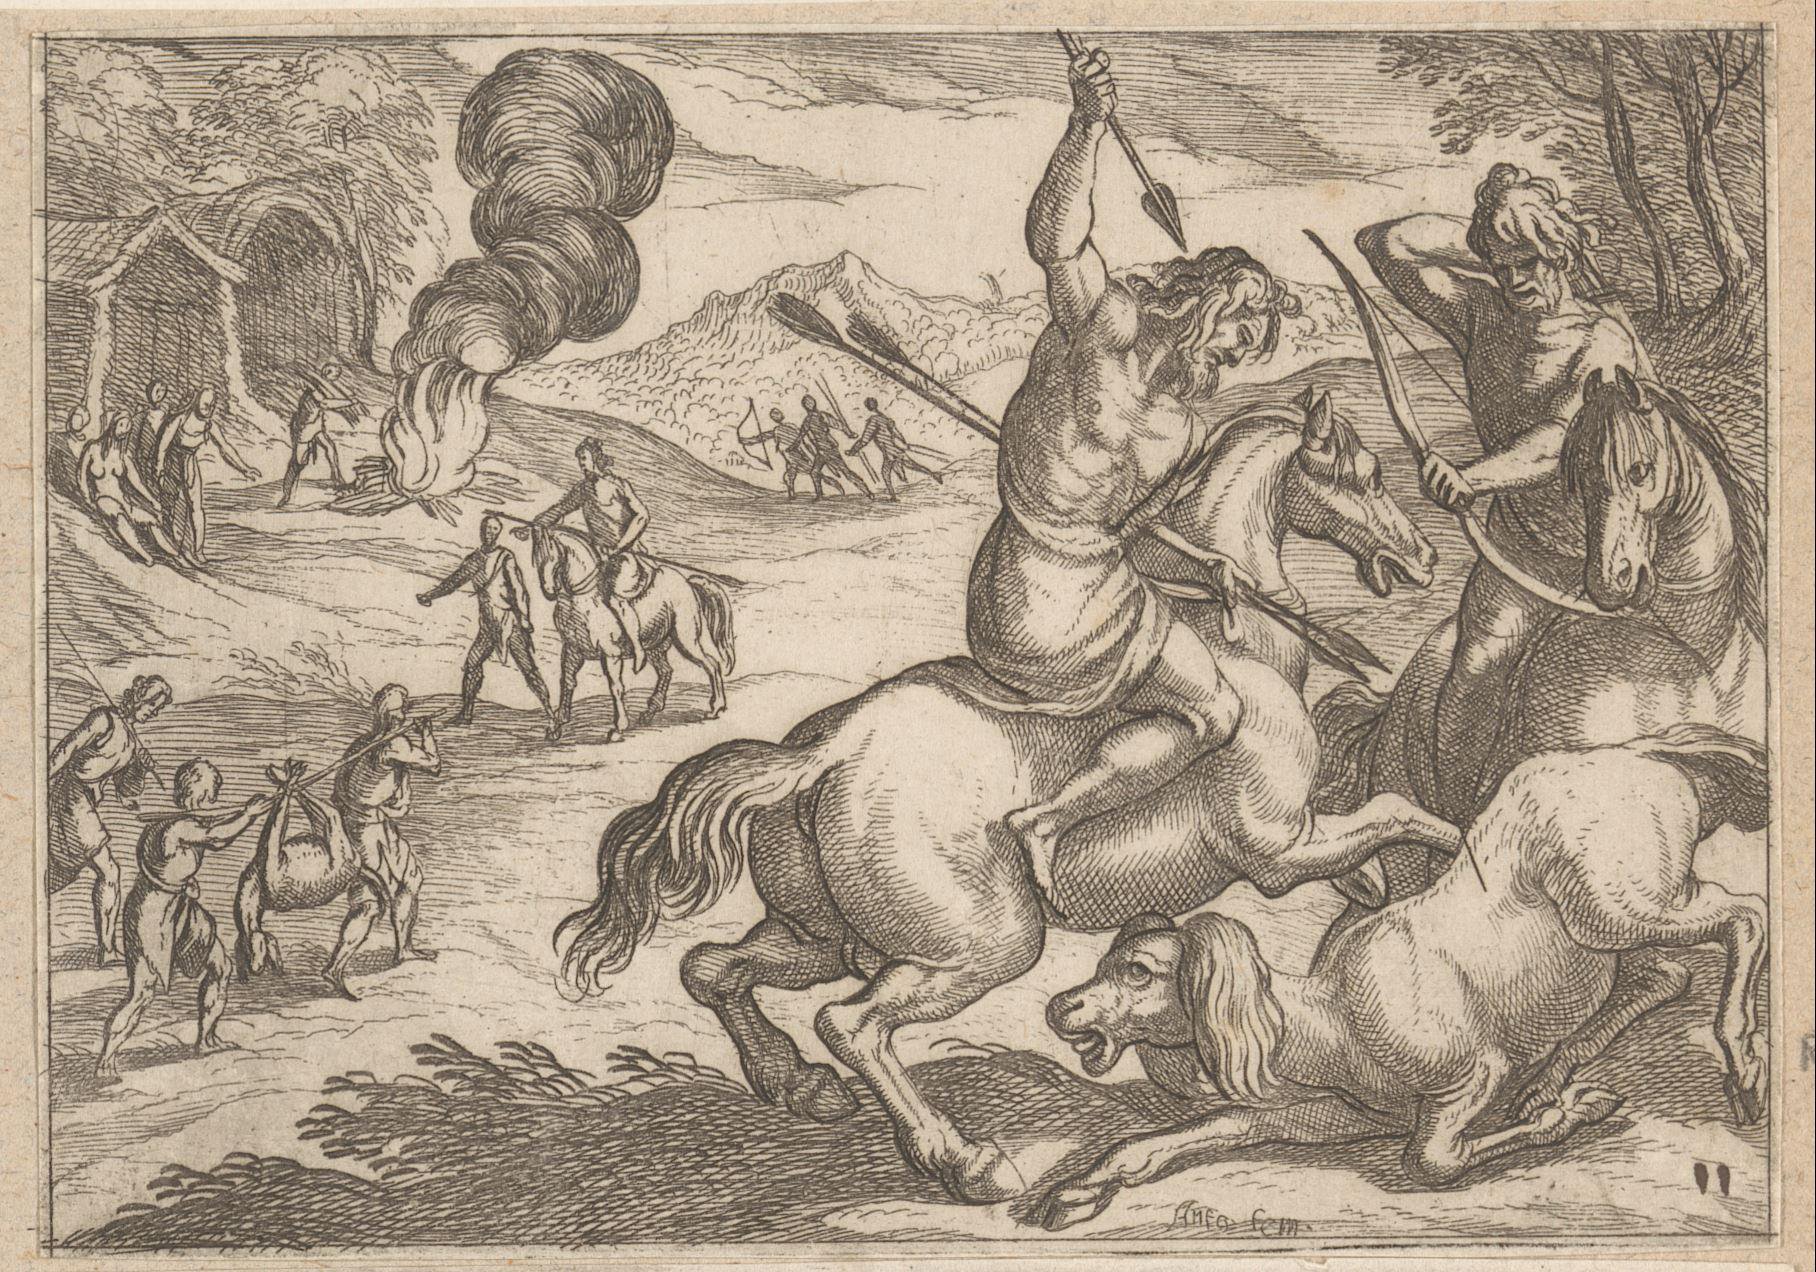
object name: print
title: Jachtscènes (deel 2)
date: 1598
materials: paper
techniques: etching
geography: vatican city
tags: hunter, hunters hunting (n.b.: in 1988-1990 this notation denoted the concept of 43c11421 'hunters resting during the hunt'), hunt ~ mammals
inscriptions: collector's mark: Lugt 11, collector's mark: ‘Hinloopen’, number: ‘11’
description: Landschap met primitieve jagers in lendendoeken te paard jagend op wilde honden (de dieren lijken meer op lama's met hangoren).